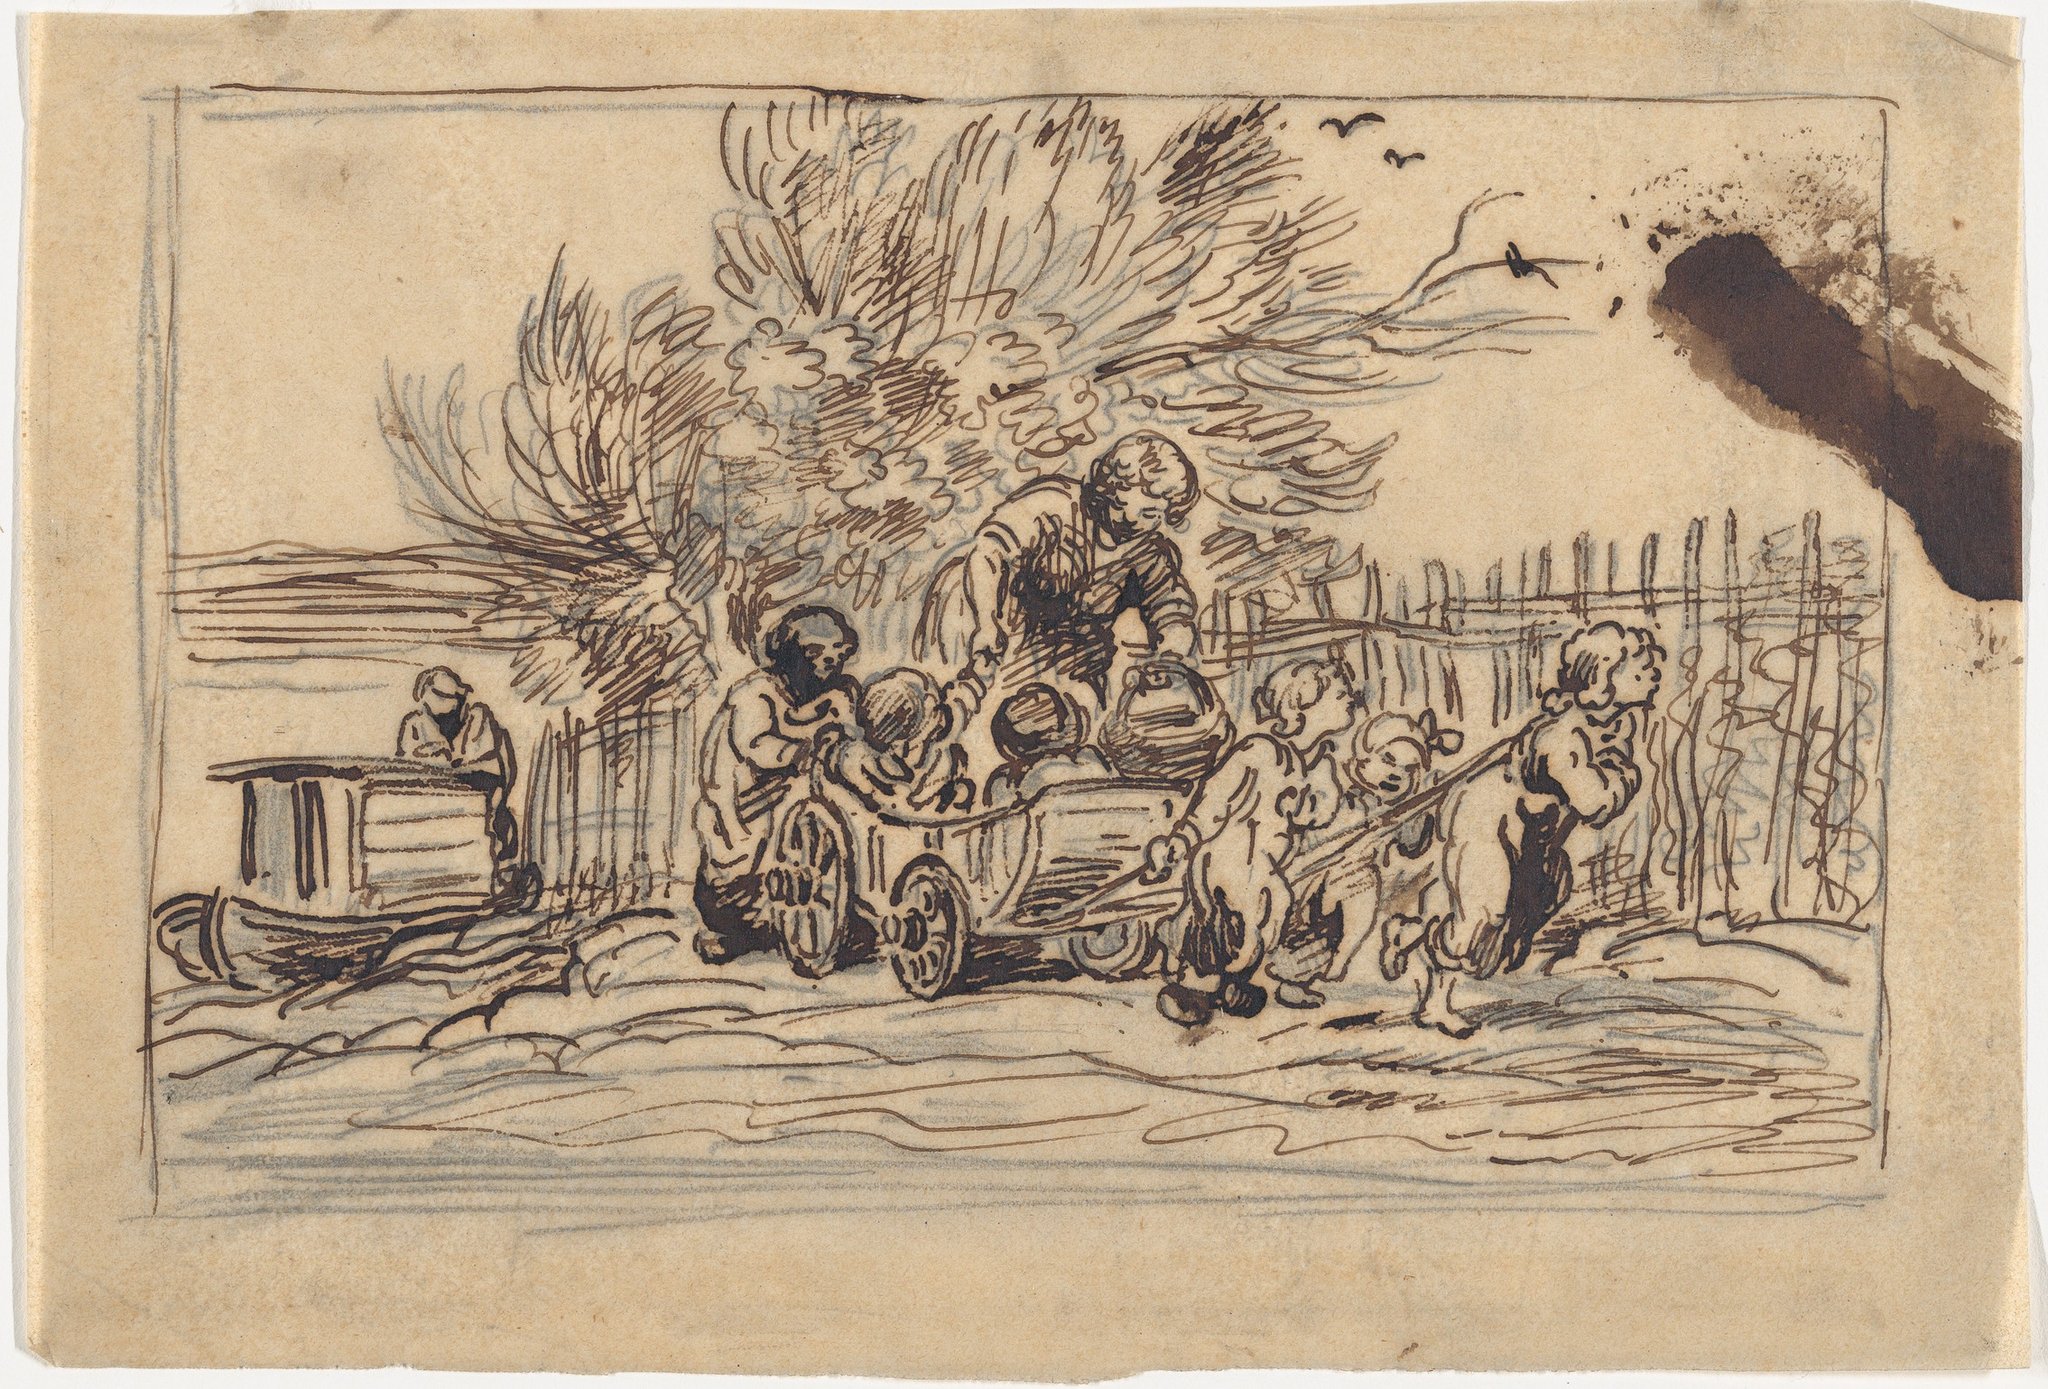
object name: drawing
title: Taking Over the Cart or Children with the Cart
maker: charles-françois daubigny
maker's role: artist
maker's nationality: french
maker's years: 1817-1878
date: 1862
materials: graphite, ink, paper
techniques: pen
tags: children,carts